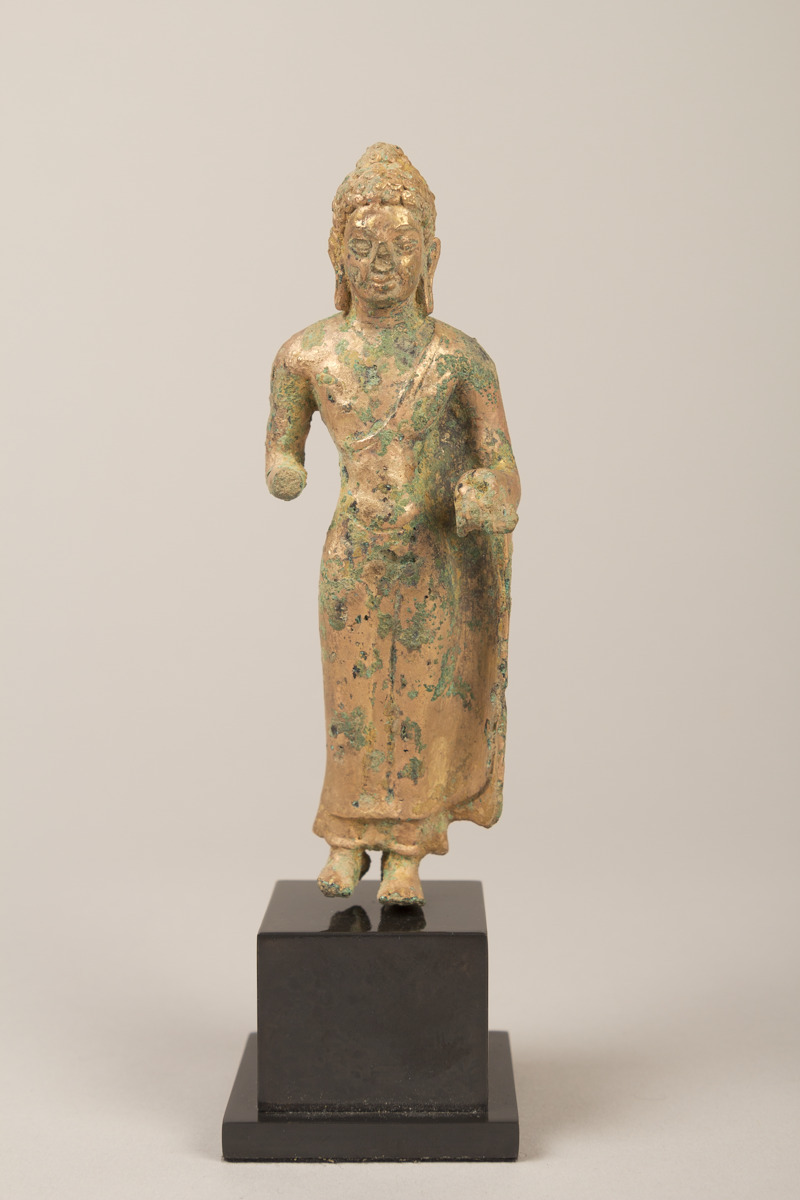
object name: fragment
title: Fragment of a Small Standing Buddha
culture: indonesian, kalimantan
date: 701-800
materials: bronze